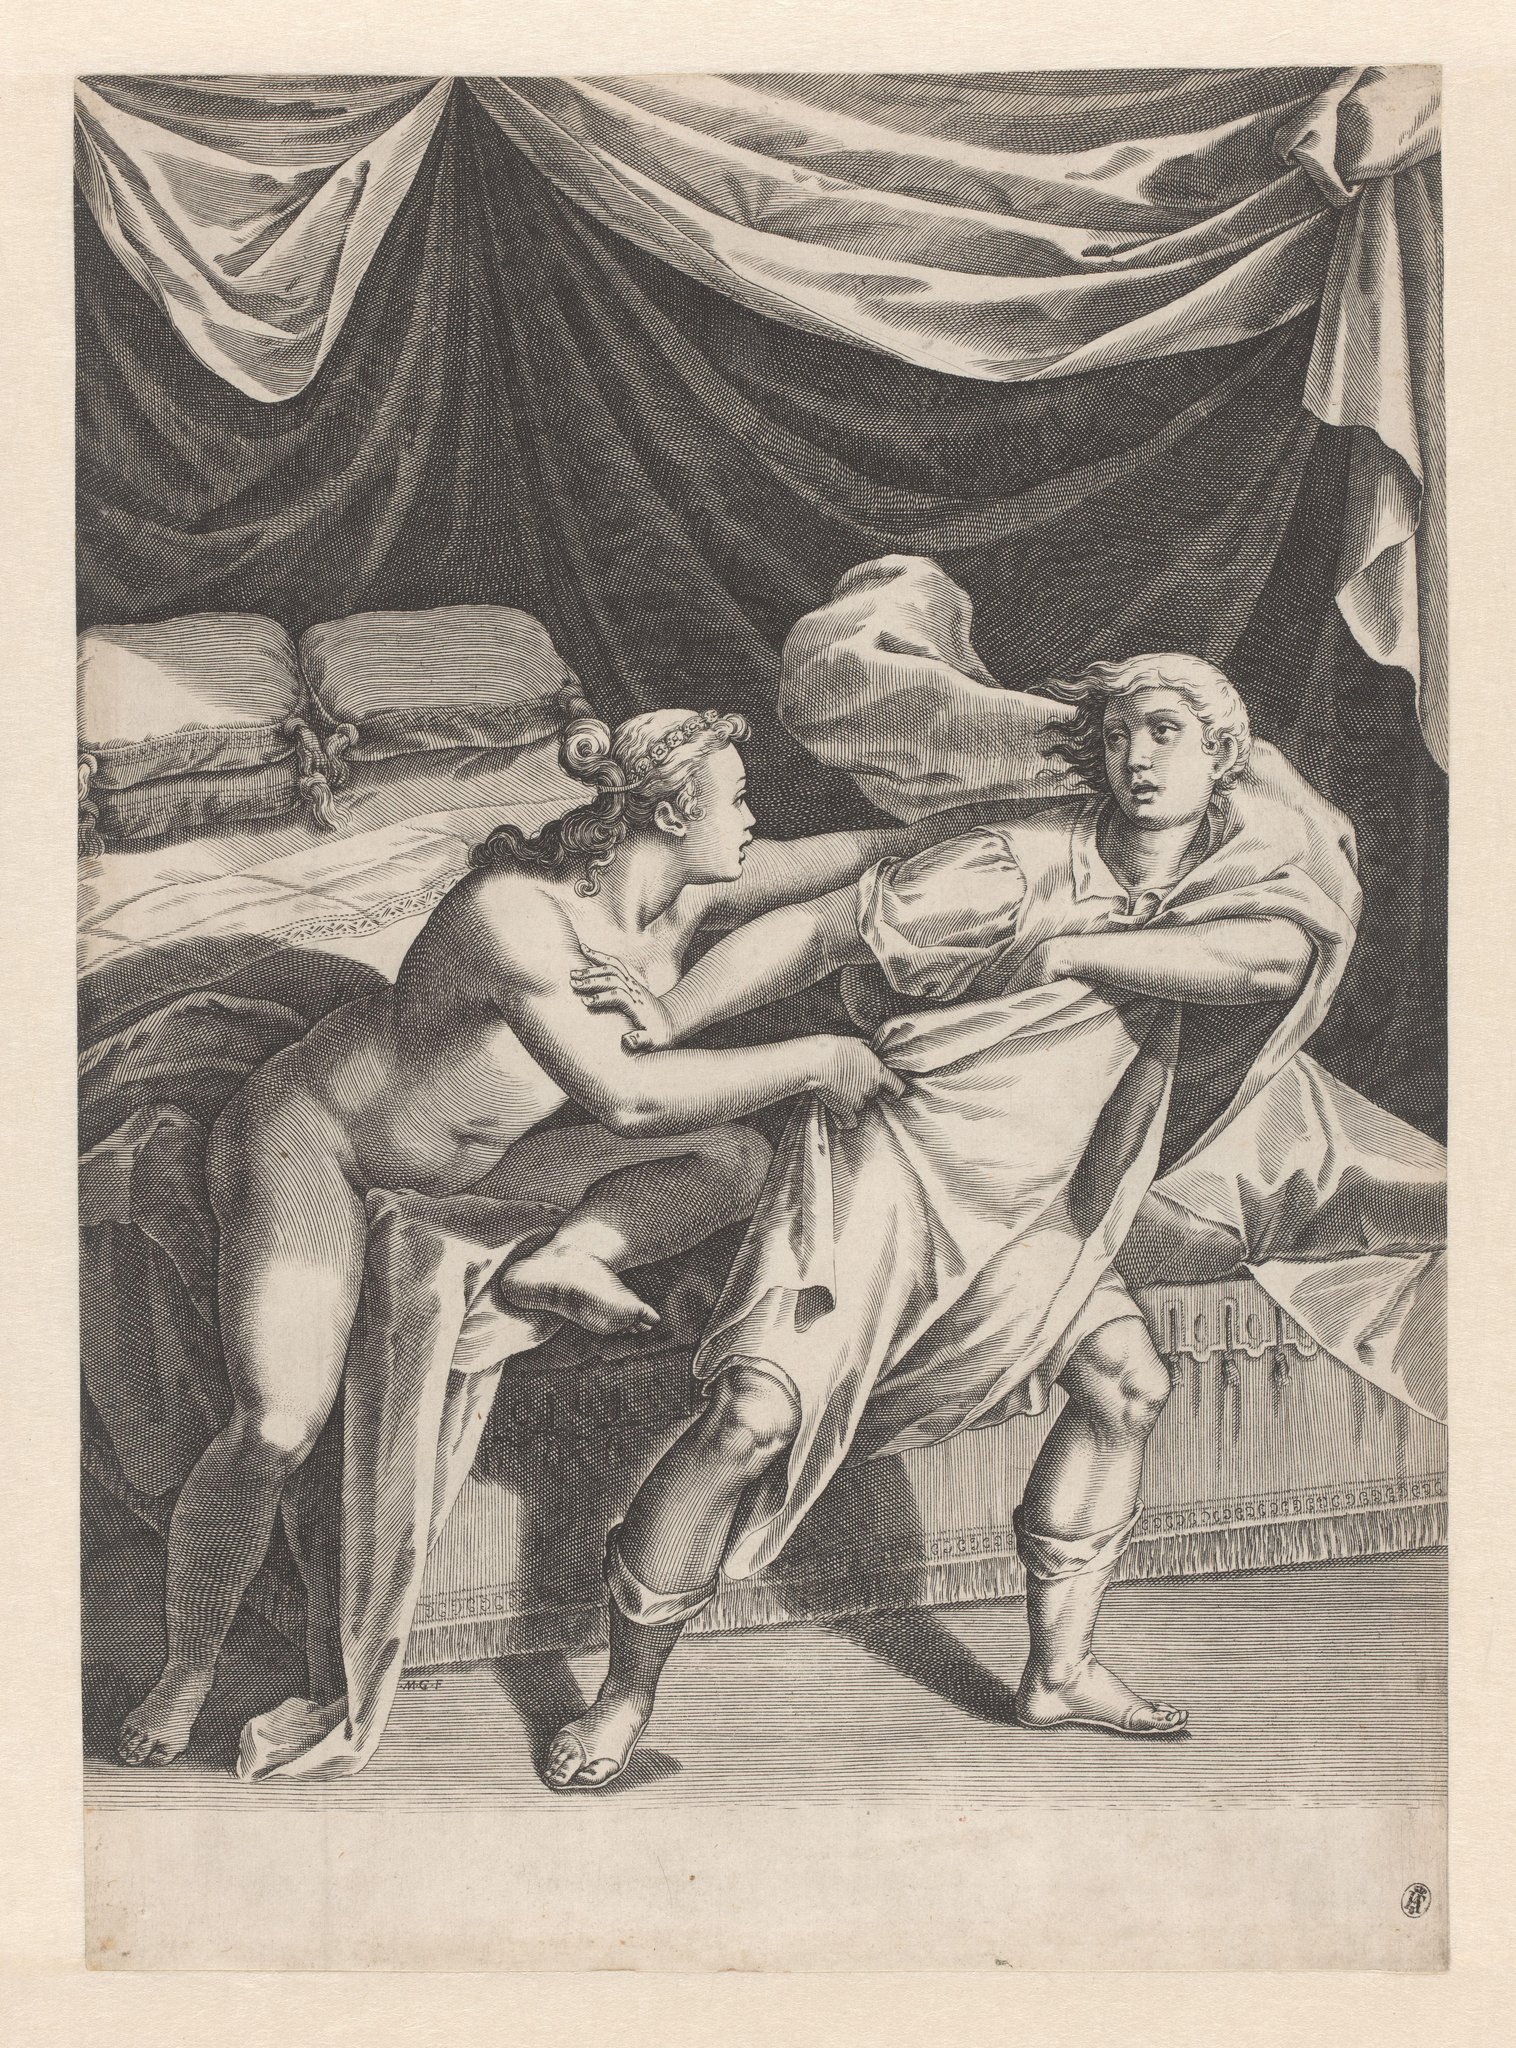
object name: print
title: Josef en de vrouw van Potifar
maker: monogrammist mg (16e eeuw)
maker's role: print maker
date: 1550-1599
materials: paper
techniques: engraving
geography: italy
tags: potiphar's wife catches joseph by his robe, usually while lying in bed; joseph escapes leaving his cloak behind in her hands (possibly with a naked child lying in a crib)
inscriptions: collector's mark: Lugt 1041c, collector's mark: Lugt 2760, collector's mark: Lugt 2228